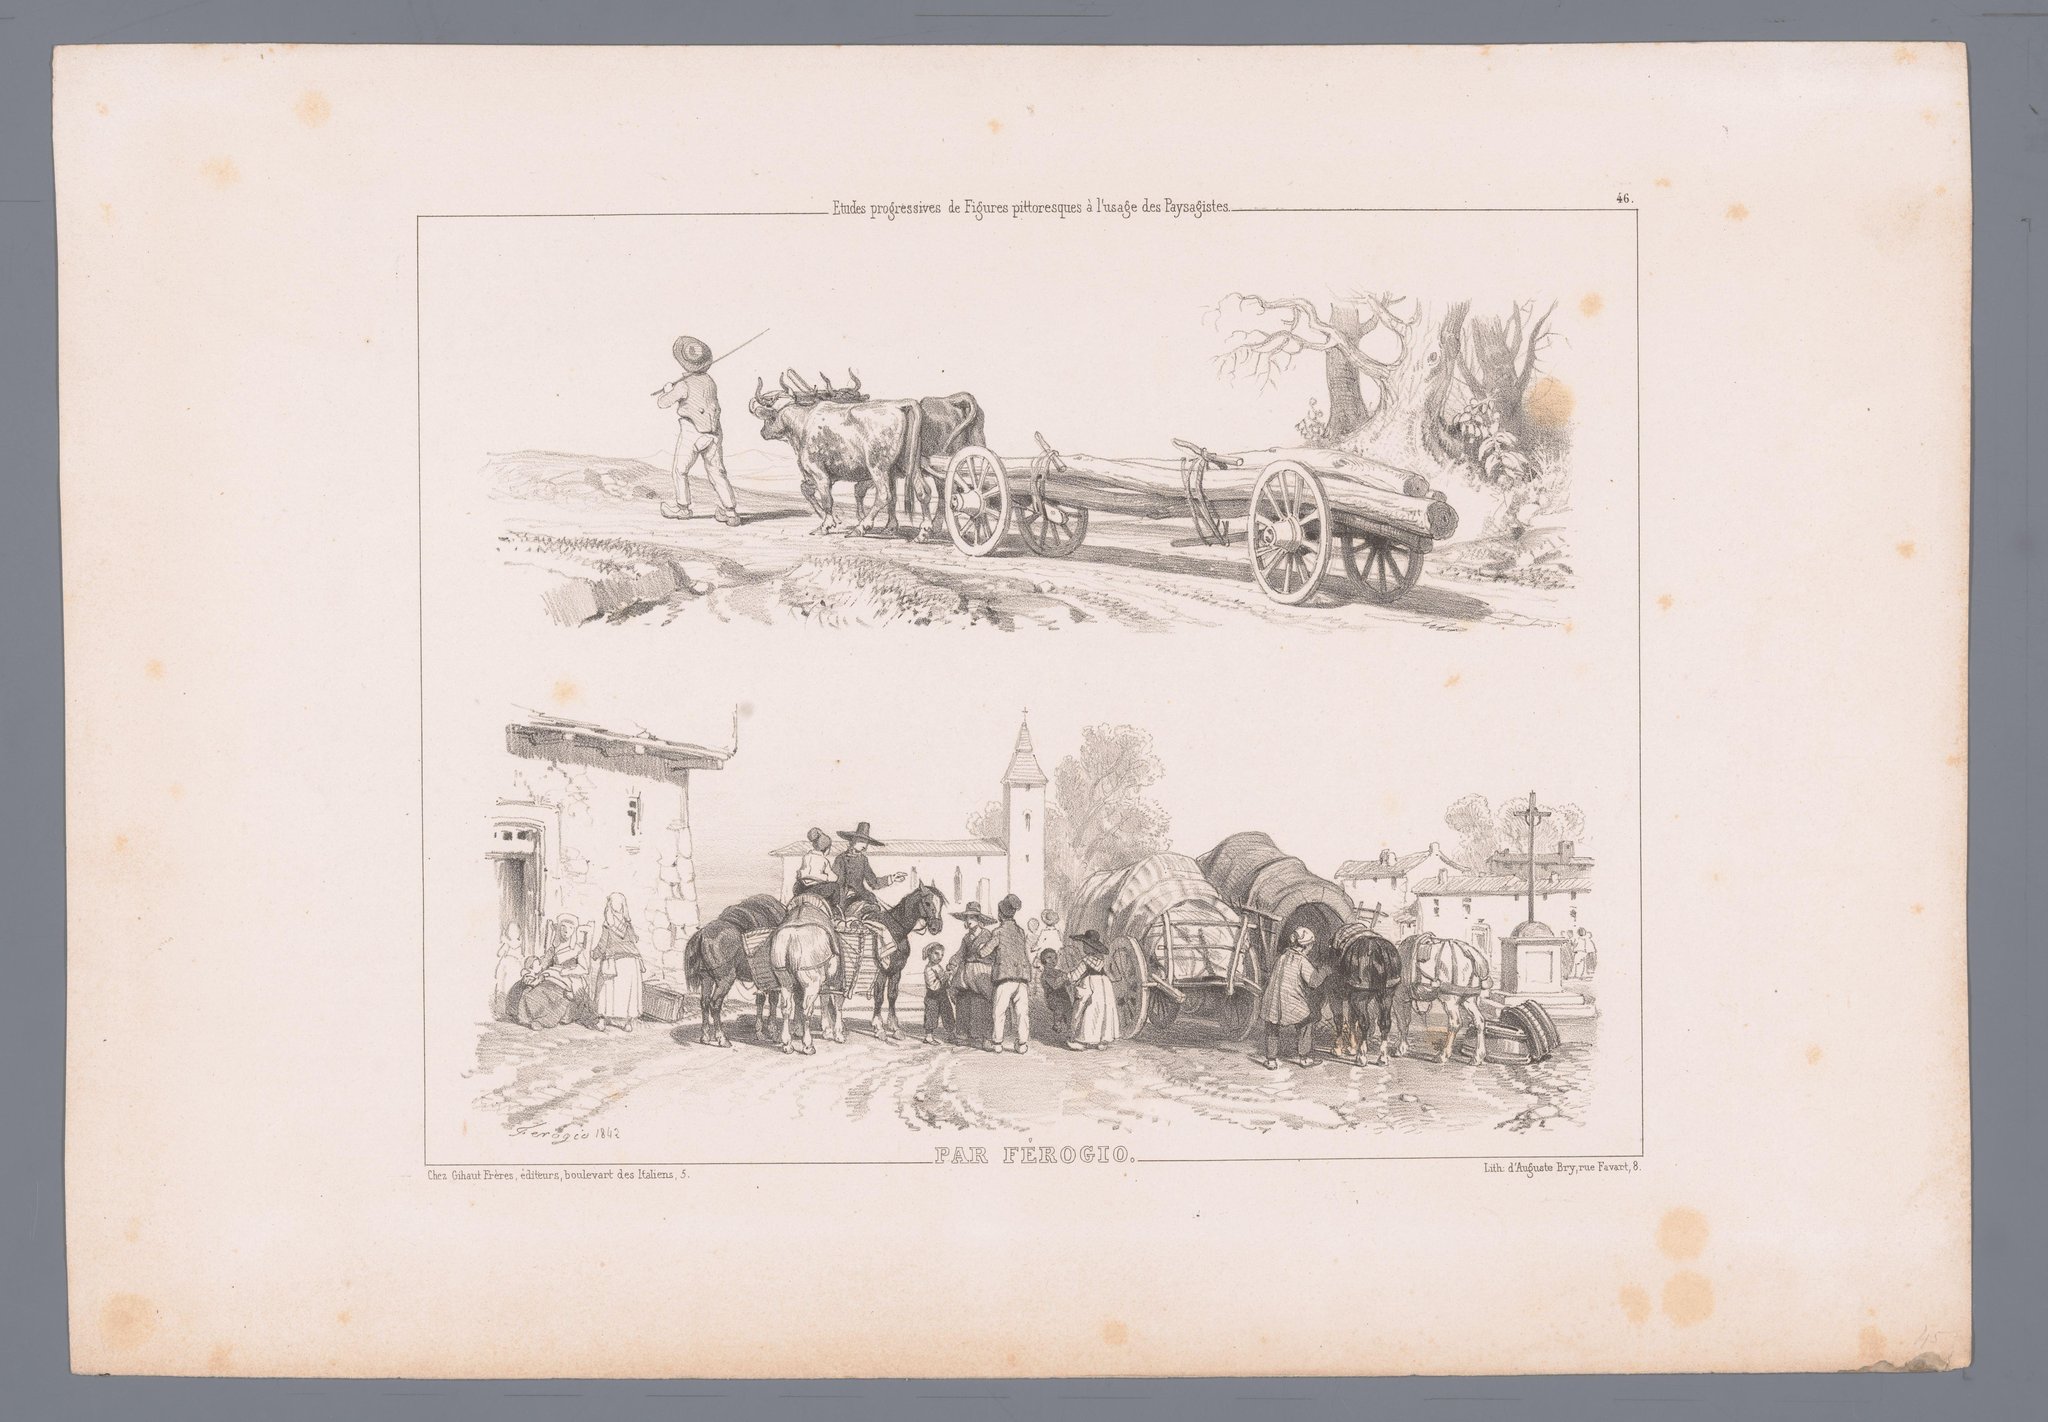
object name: print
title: Voorbeelden van figuurstudies voor landschapskunstenaars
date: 1839-1845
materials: paper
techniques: lithograph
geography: paris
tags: trees (+ stem, trunk), covered wagon, hooded wagon, ox, four-wheeled vehicle drawn by two animals, village square, place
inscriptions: collector's mark: Lugt 2228a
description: Prent maakt deel uit van een omslag met vijf prenten.